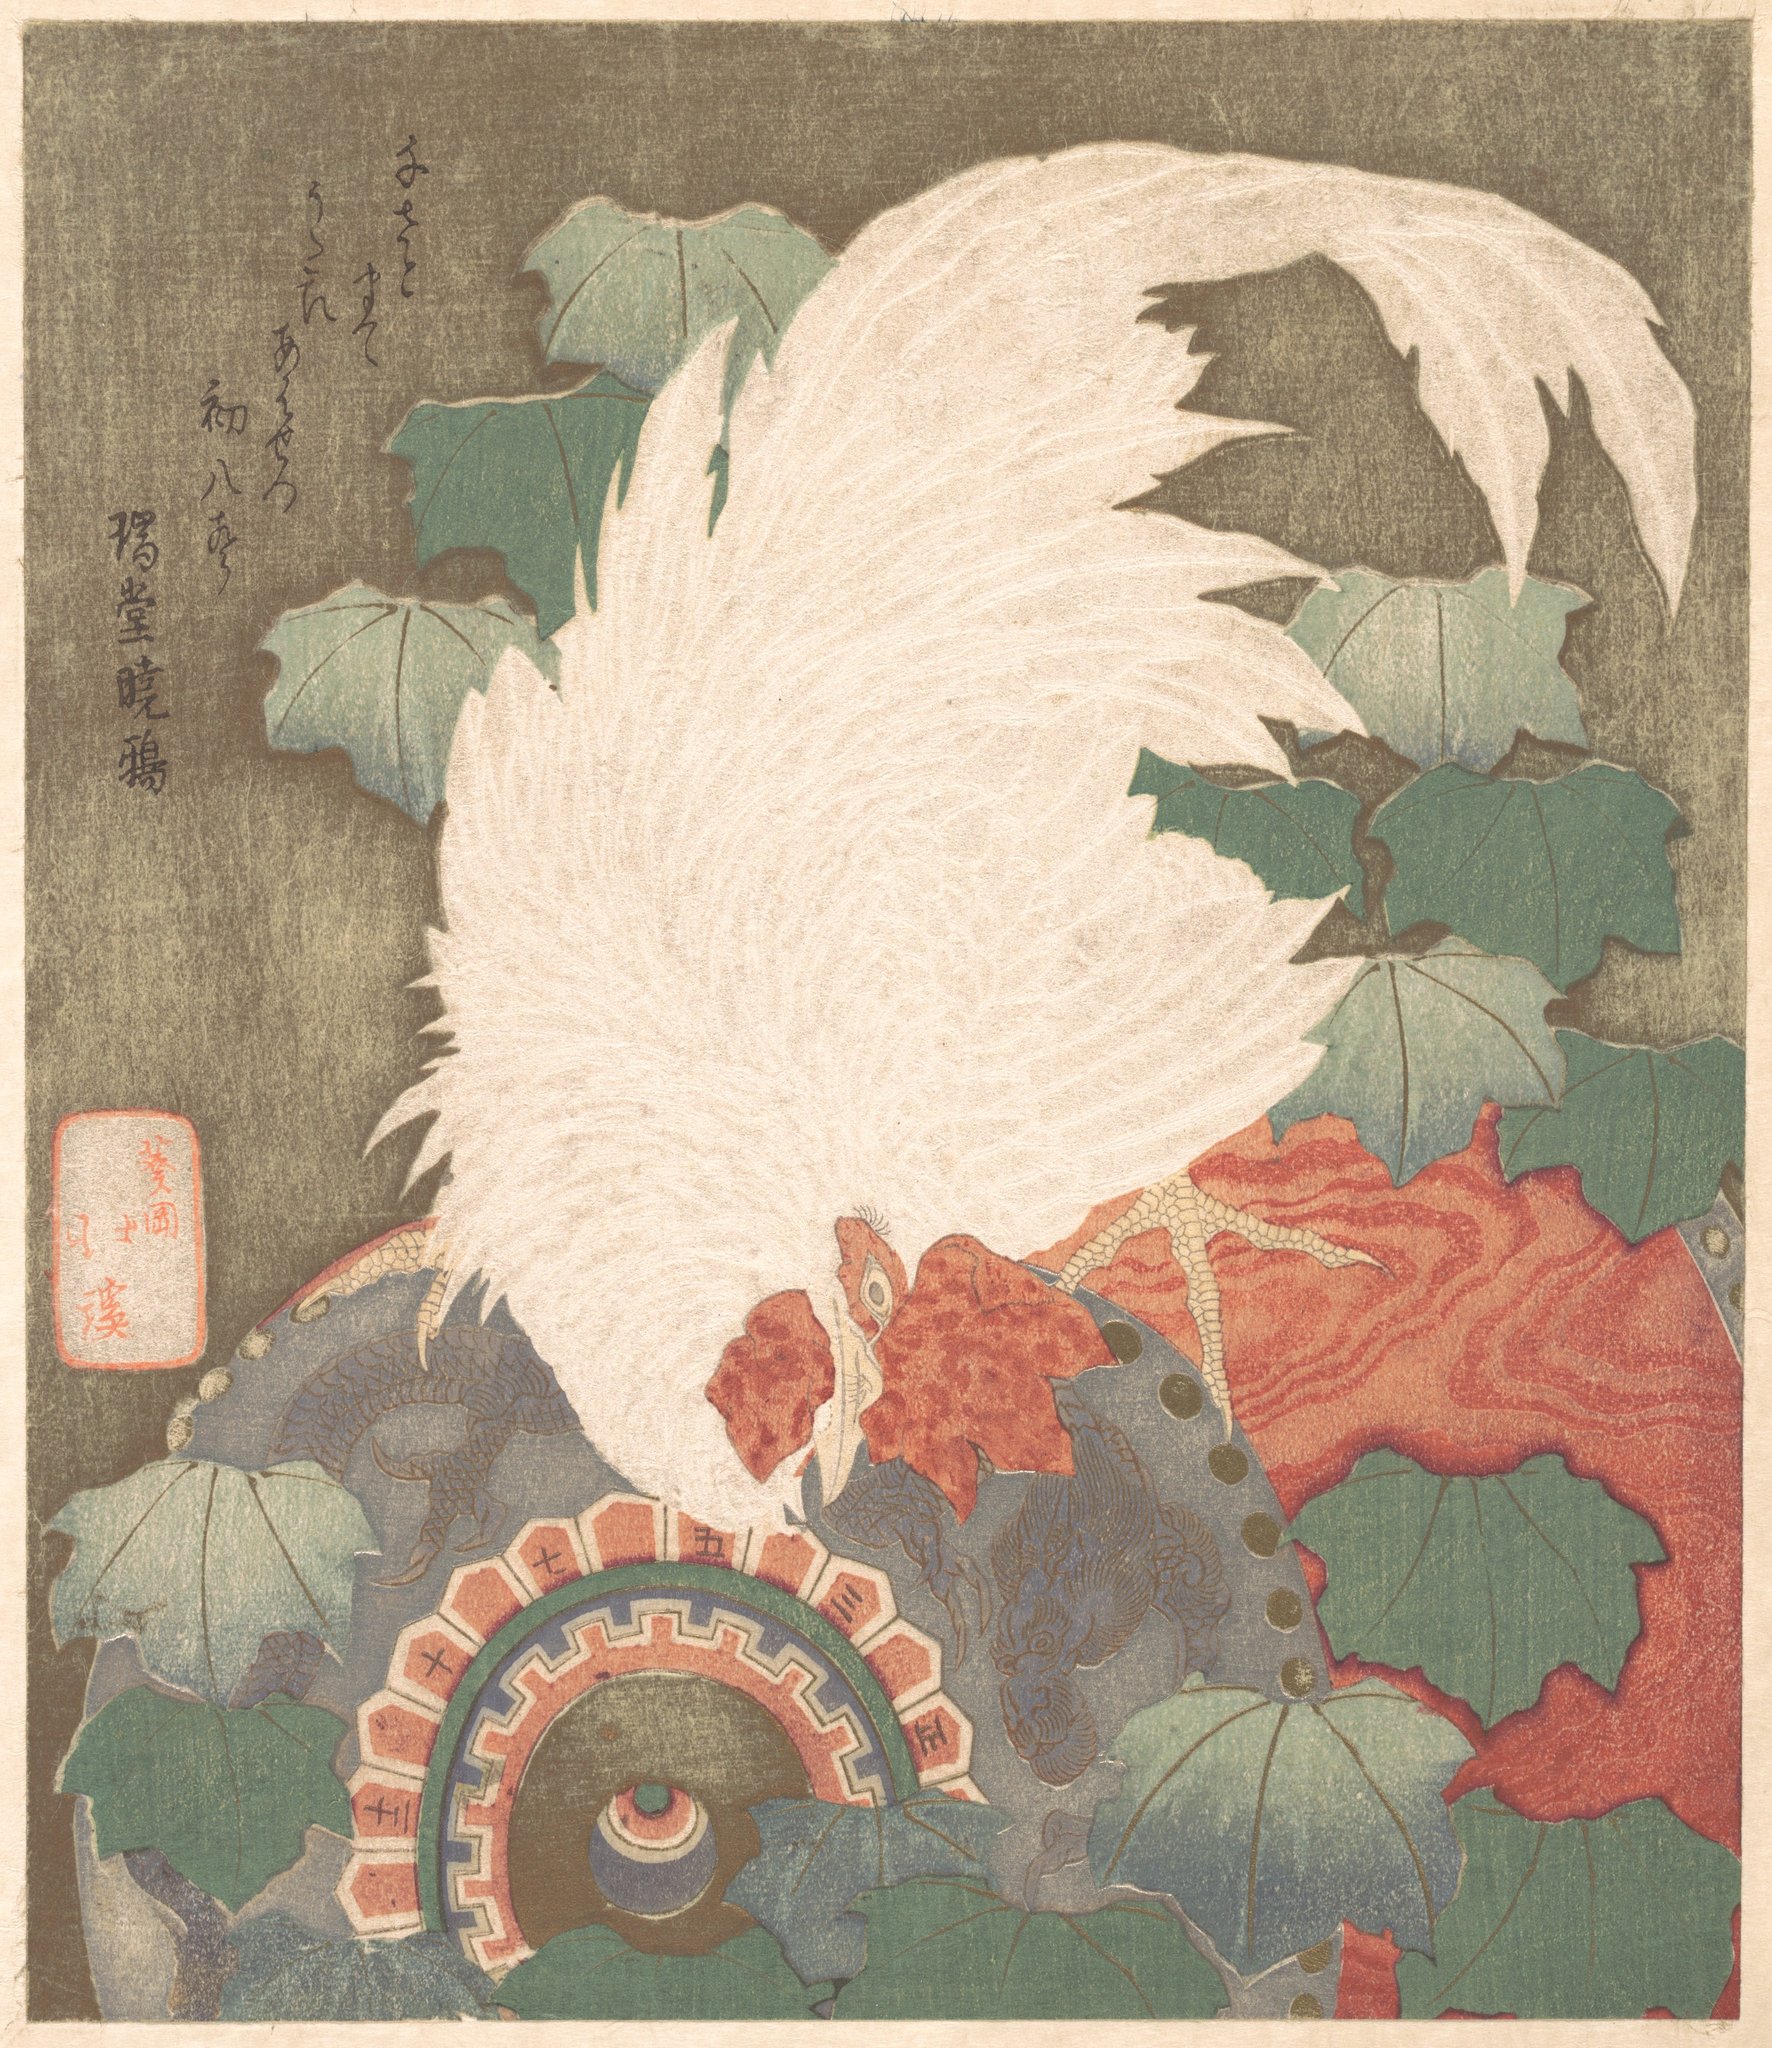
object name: print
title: Cock on Drum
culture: japanese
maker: totoya hokkei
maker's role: artist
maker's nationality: japanese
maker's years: 1780-1850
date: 1825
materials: ink, paper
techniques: surimono, woodblock print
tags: roosters,leaves